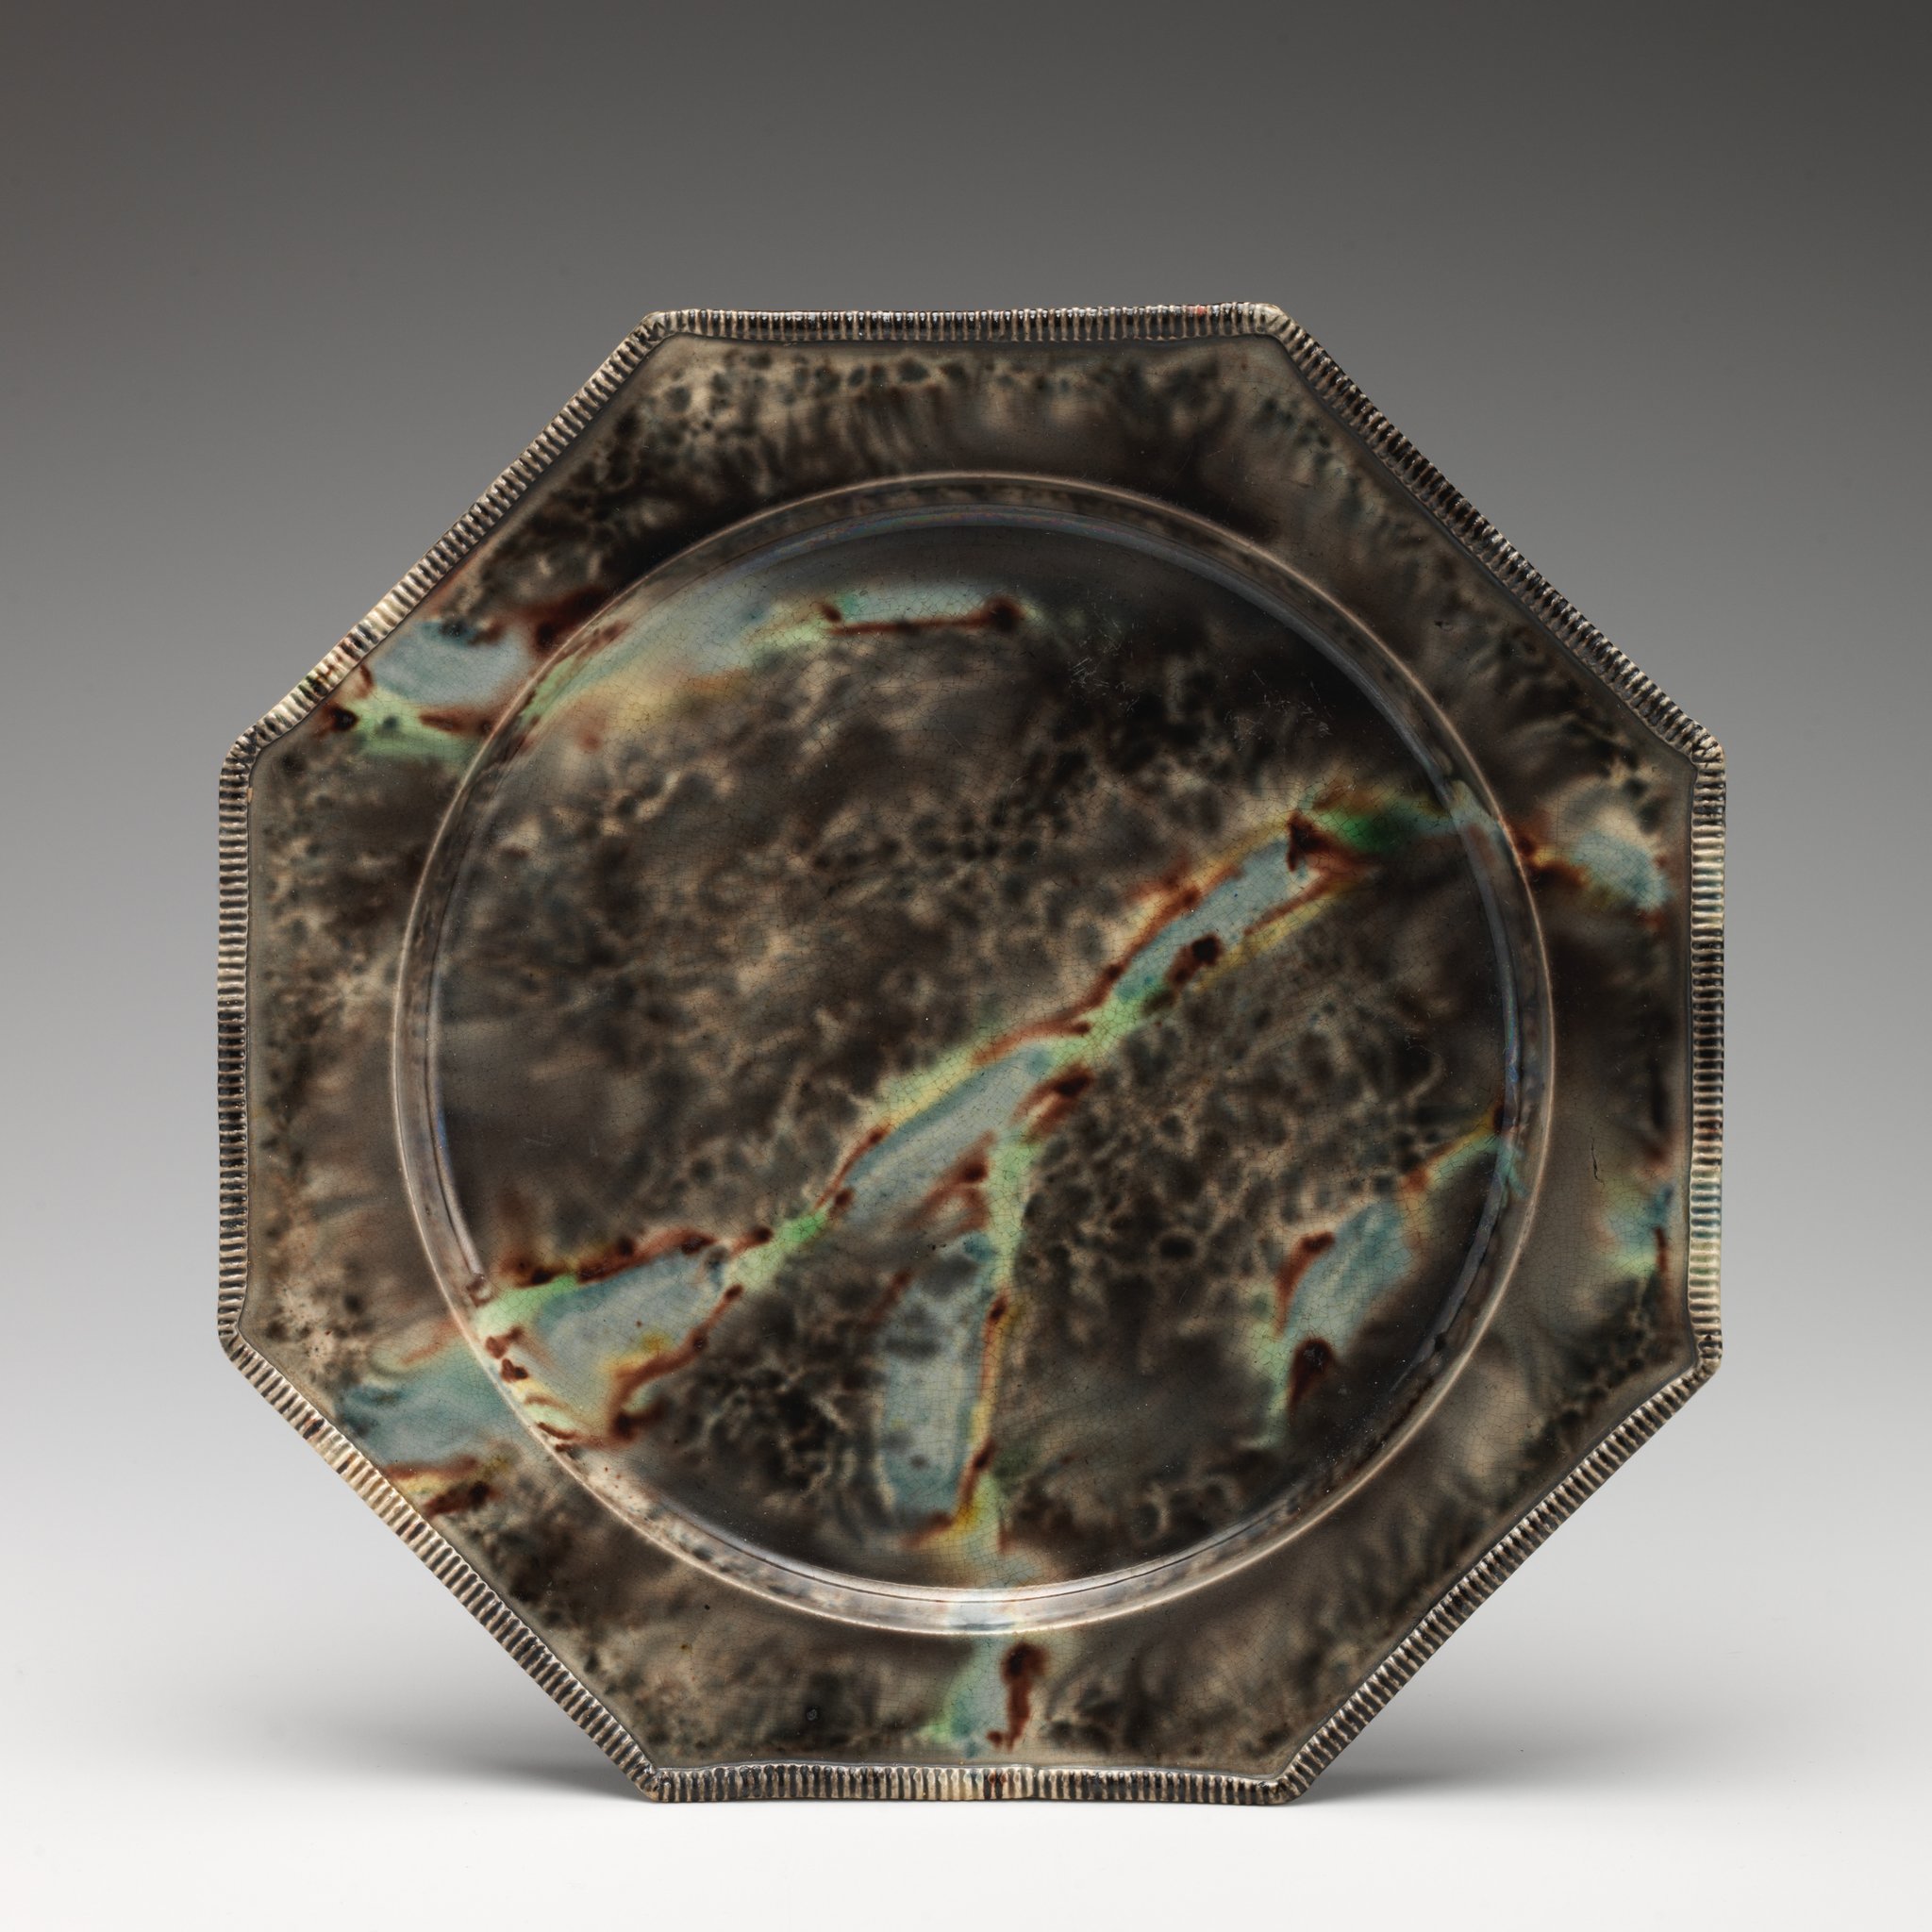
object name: plate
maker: whieldon type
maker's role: maker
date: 1750-1770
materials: earthenware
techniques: glazing